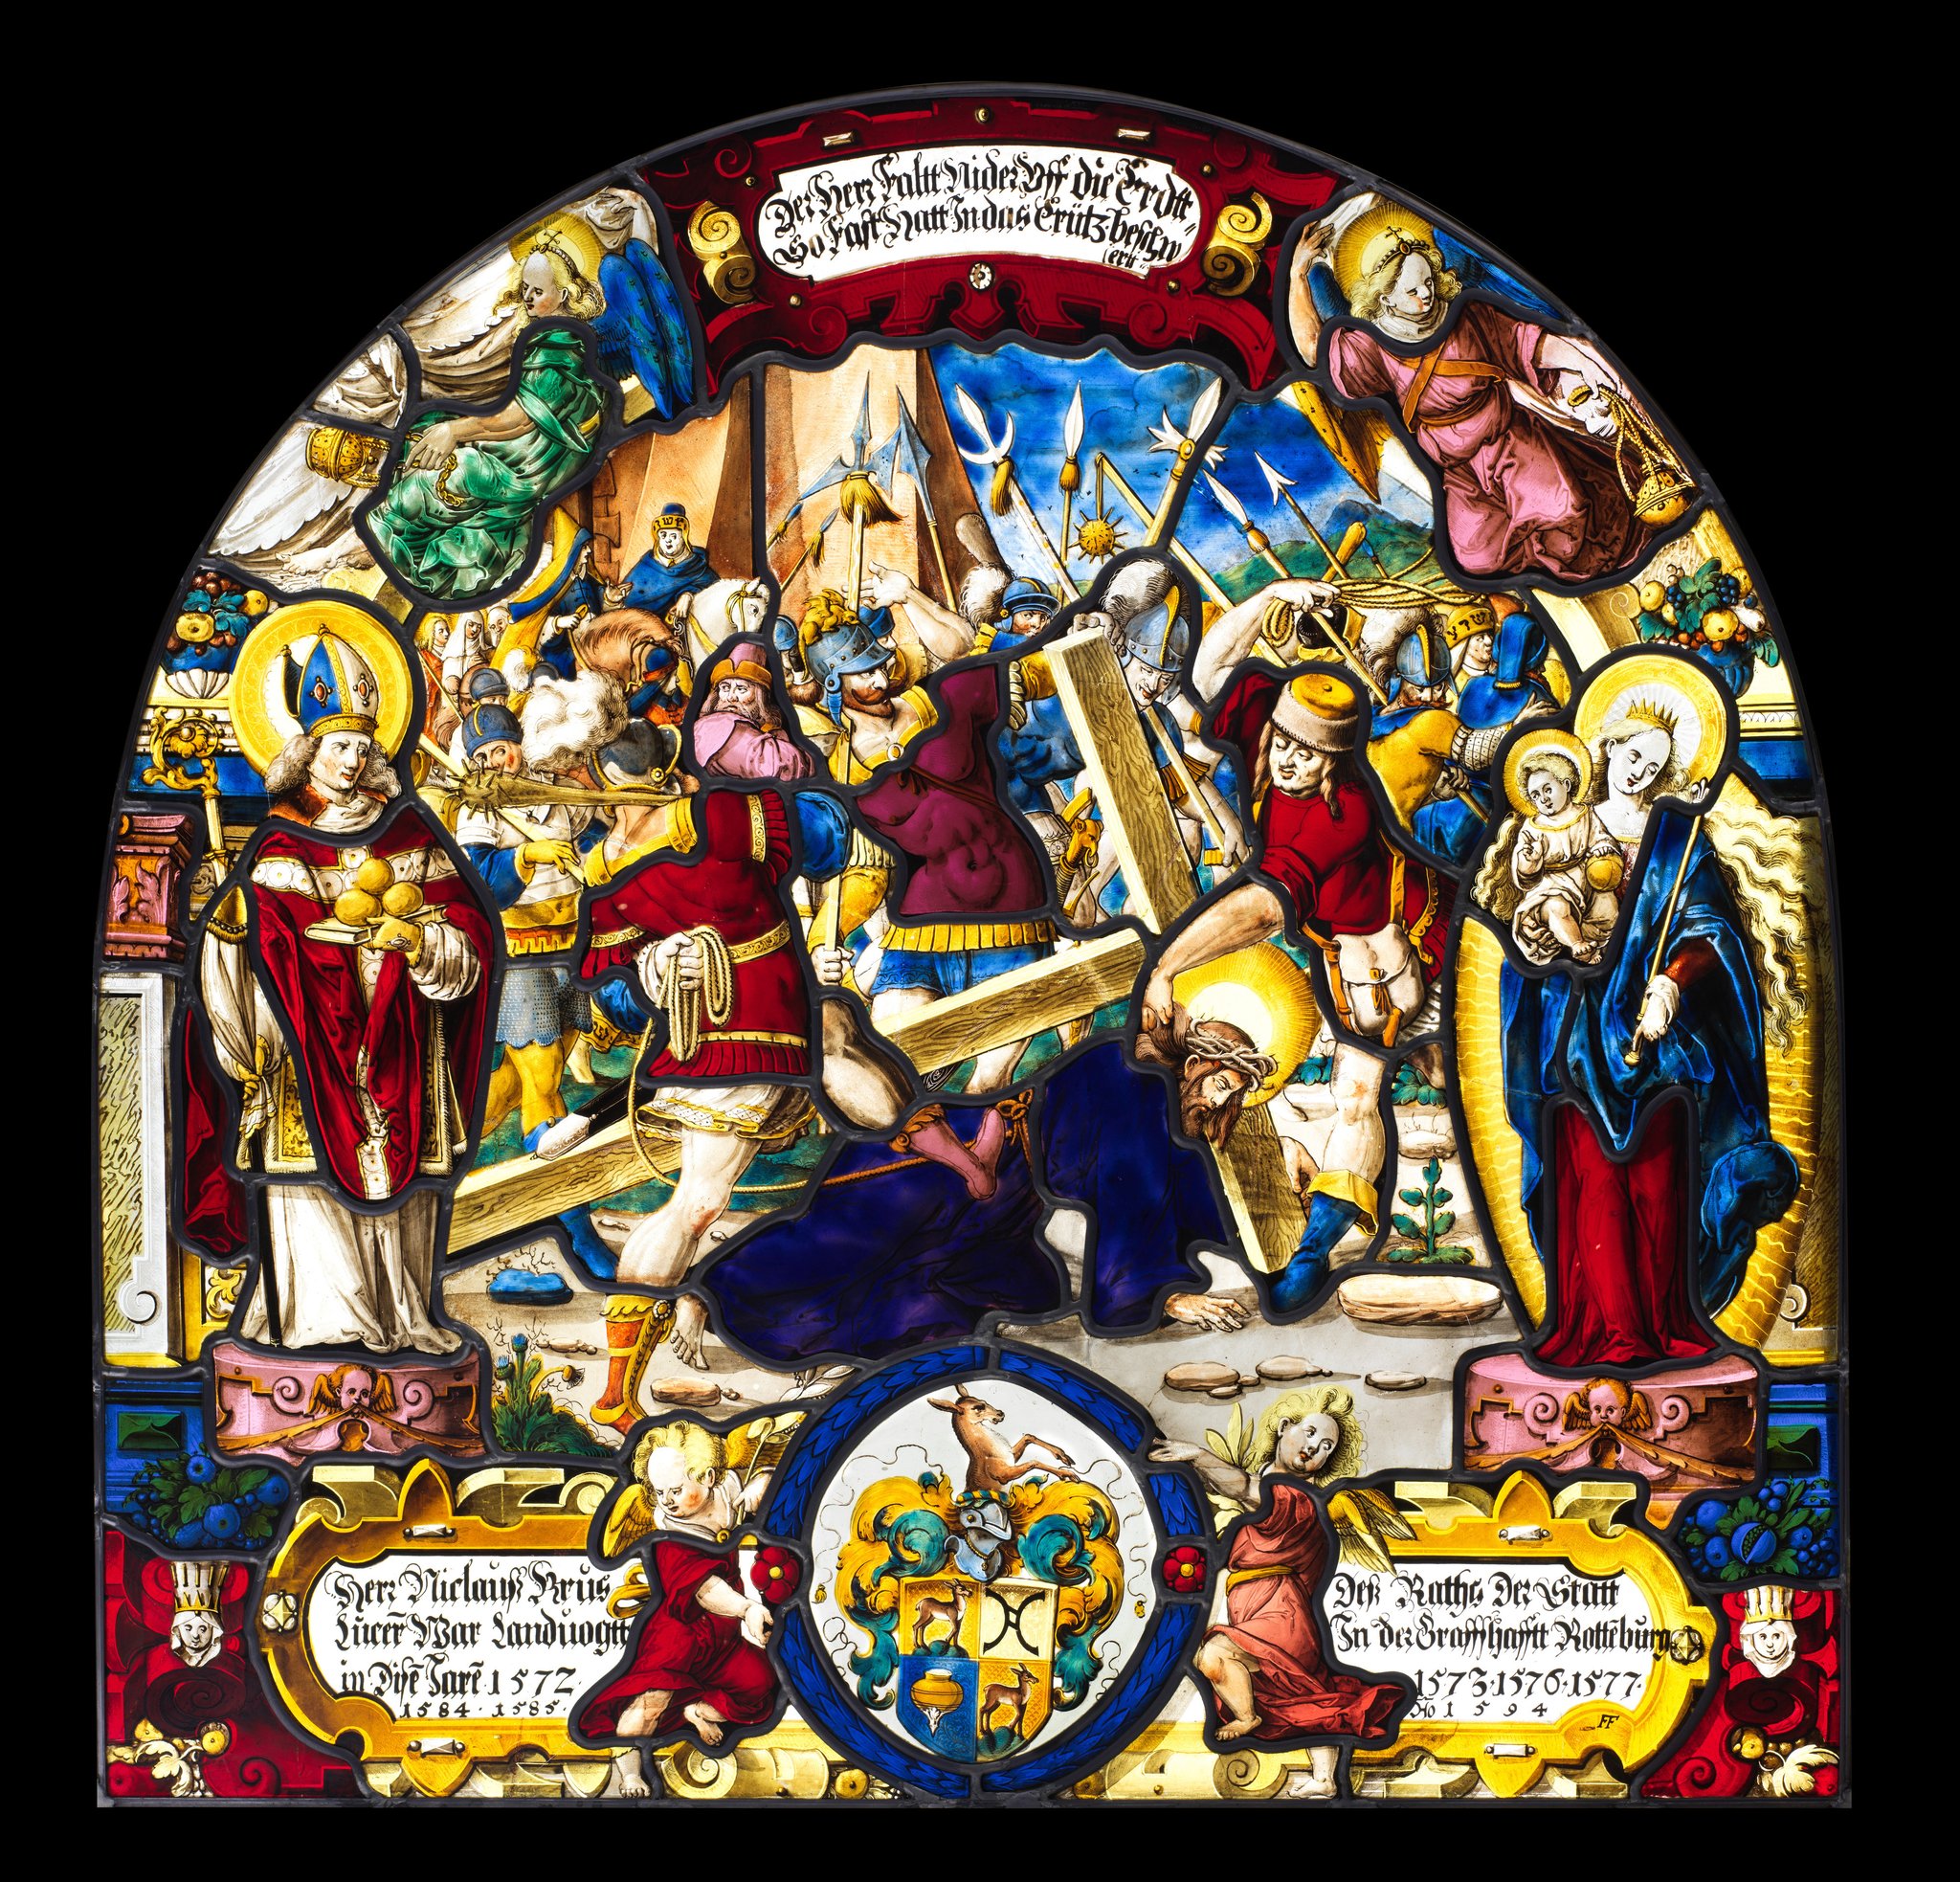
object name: panel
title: Christ Falling Under the Cross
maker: franz fallenter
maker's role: artist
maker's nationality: german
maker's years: 1550-1616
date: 1594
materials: glass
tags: christ,madonna and child,cross,coat of arms